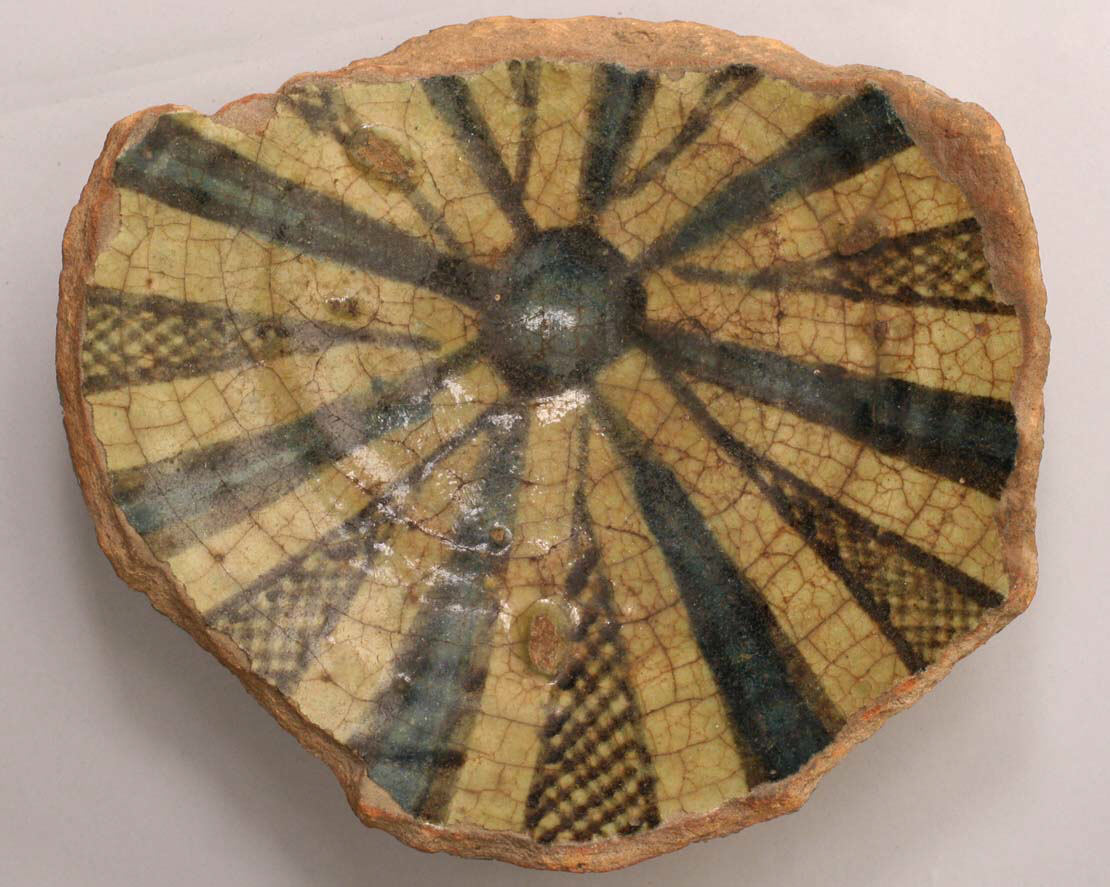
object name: fragment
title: Fragment of a Bowl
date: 1301-1500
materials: earthenware, glaze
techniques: incising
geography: egypt